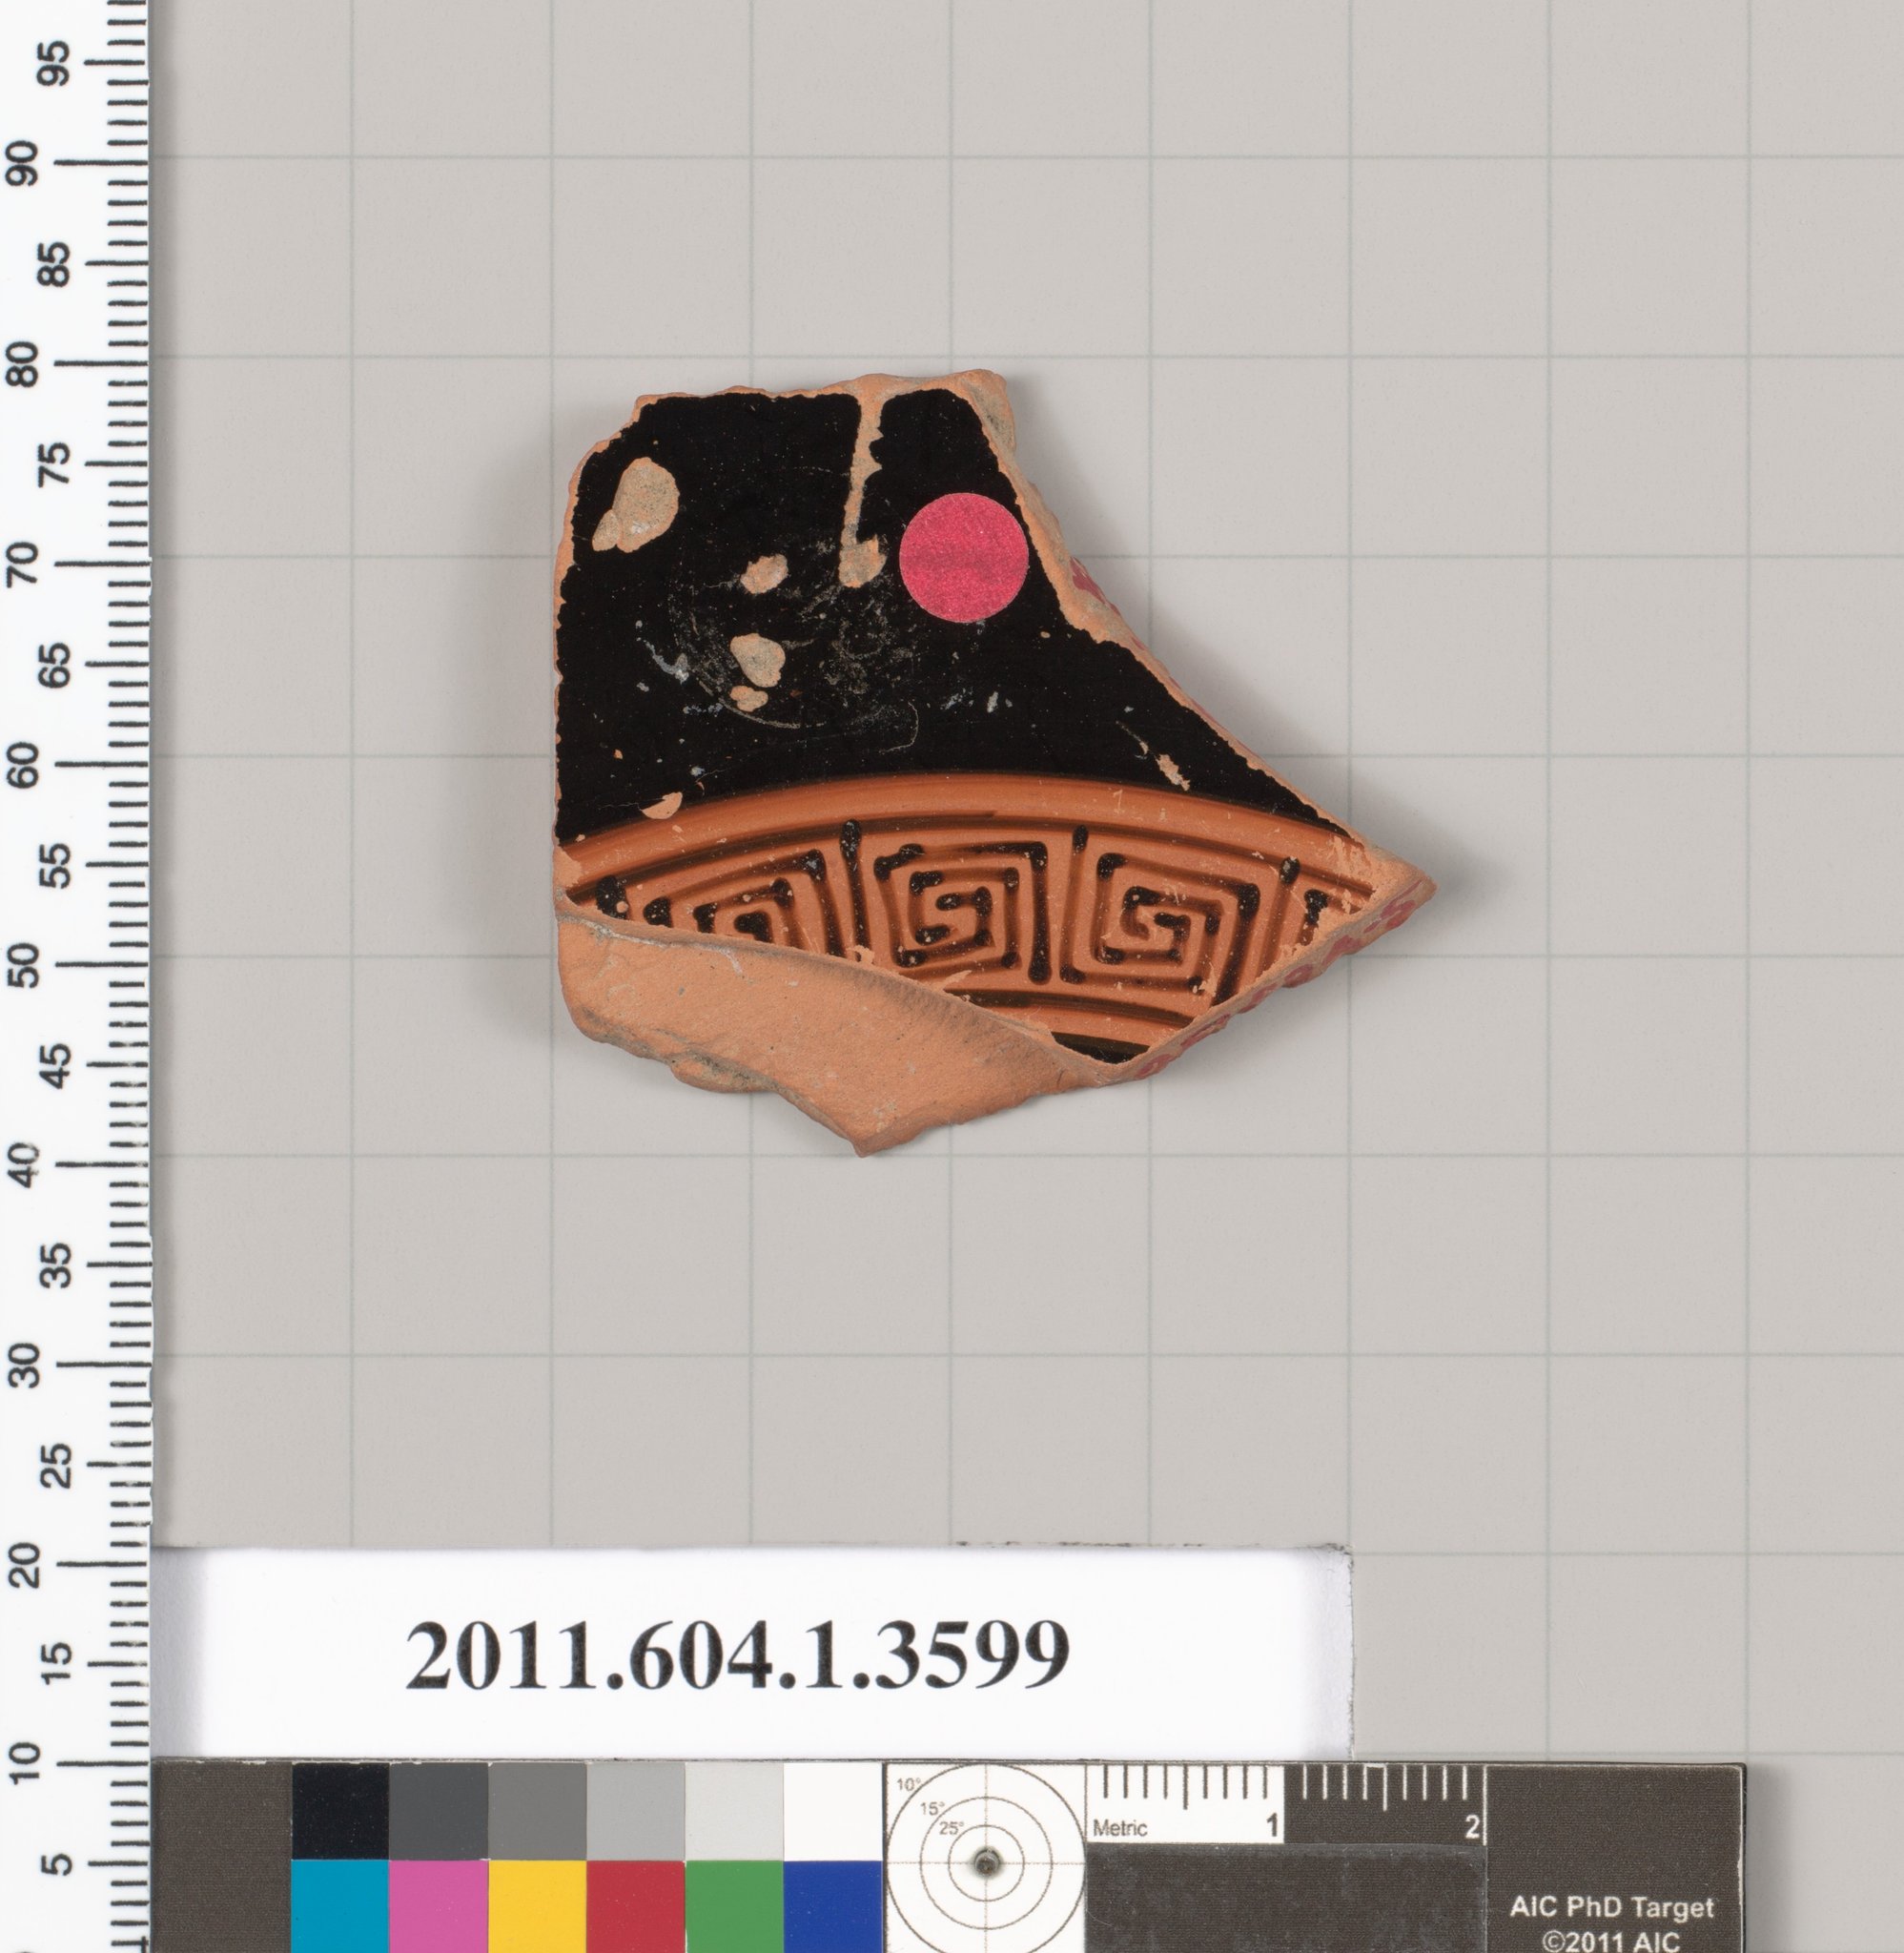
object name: kylix fragment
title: Terracotta fragment of a kylix (drinking cup)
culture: greek, attic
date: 475-451 BCE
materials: terracotta